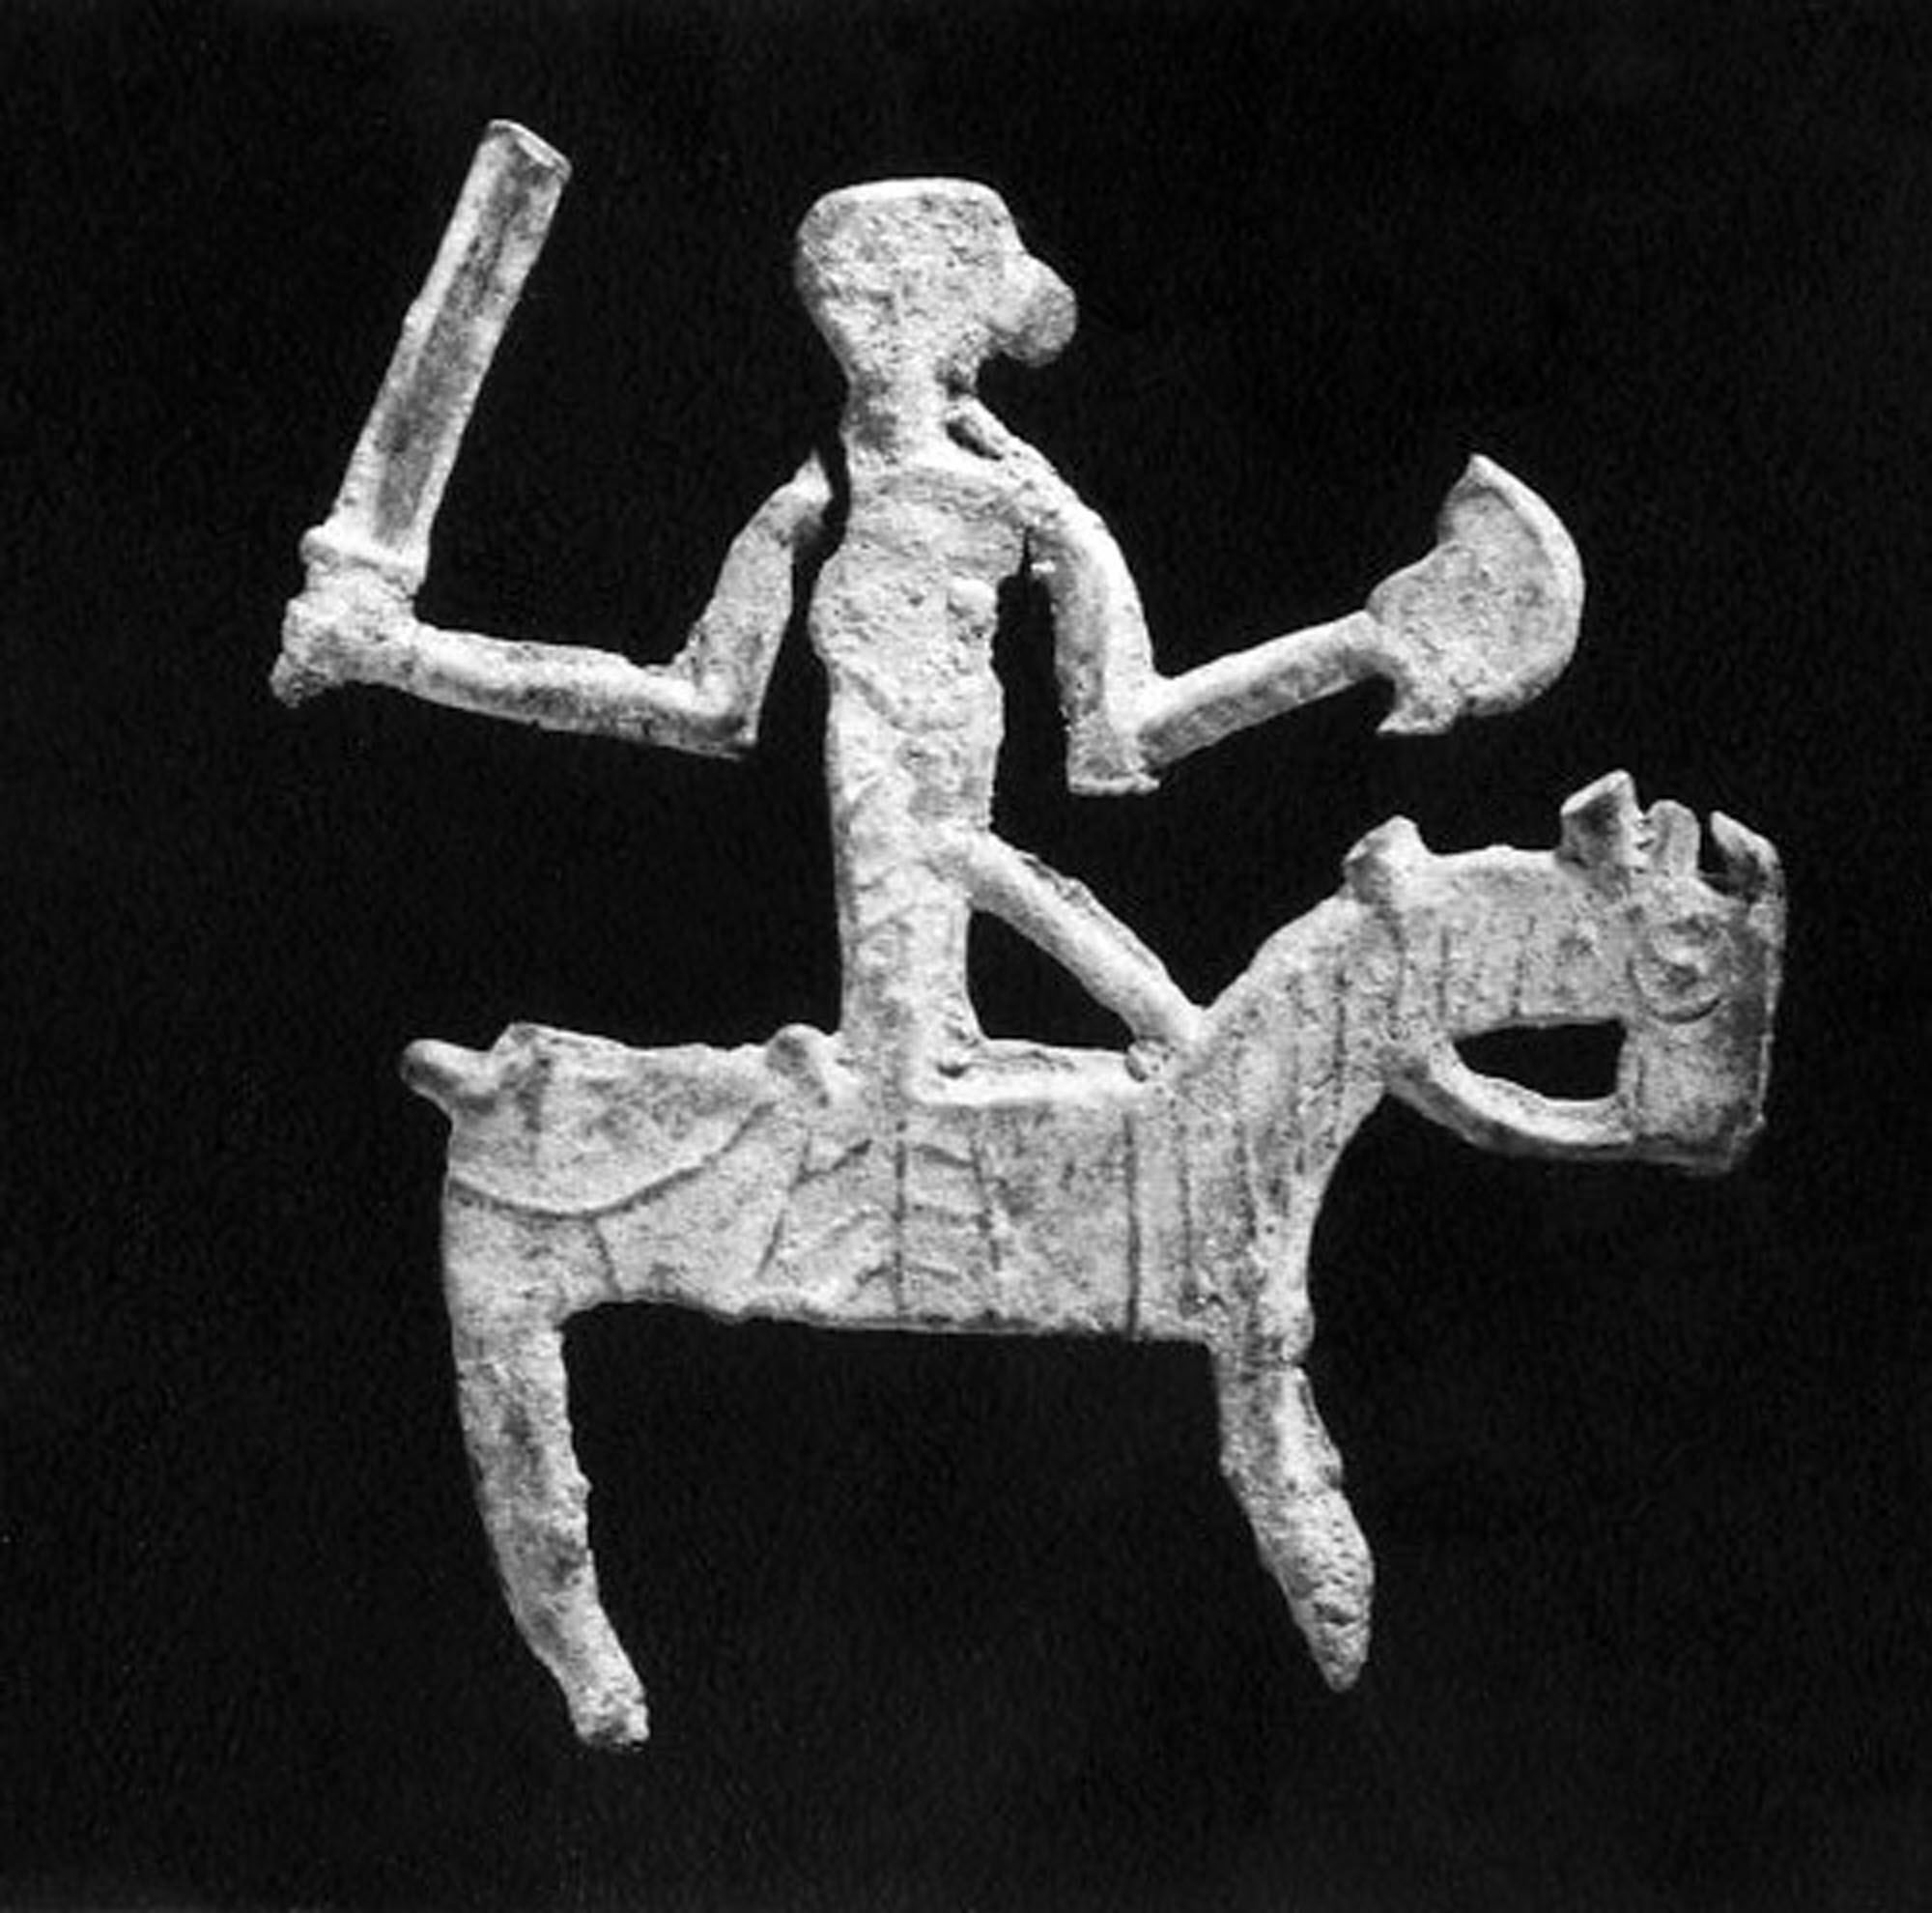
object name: plaque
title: Plaque in the shape of a horse and rider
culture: chinese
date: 201-600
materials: lead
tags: horses